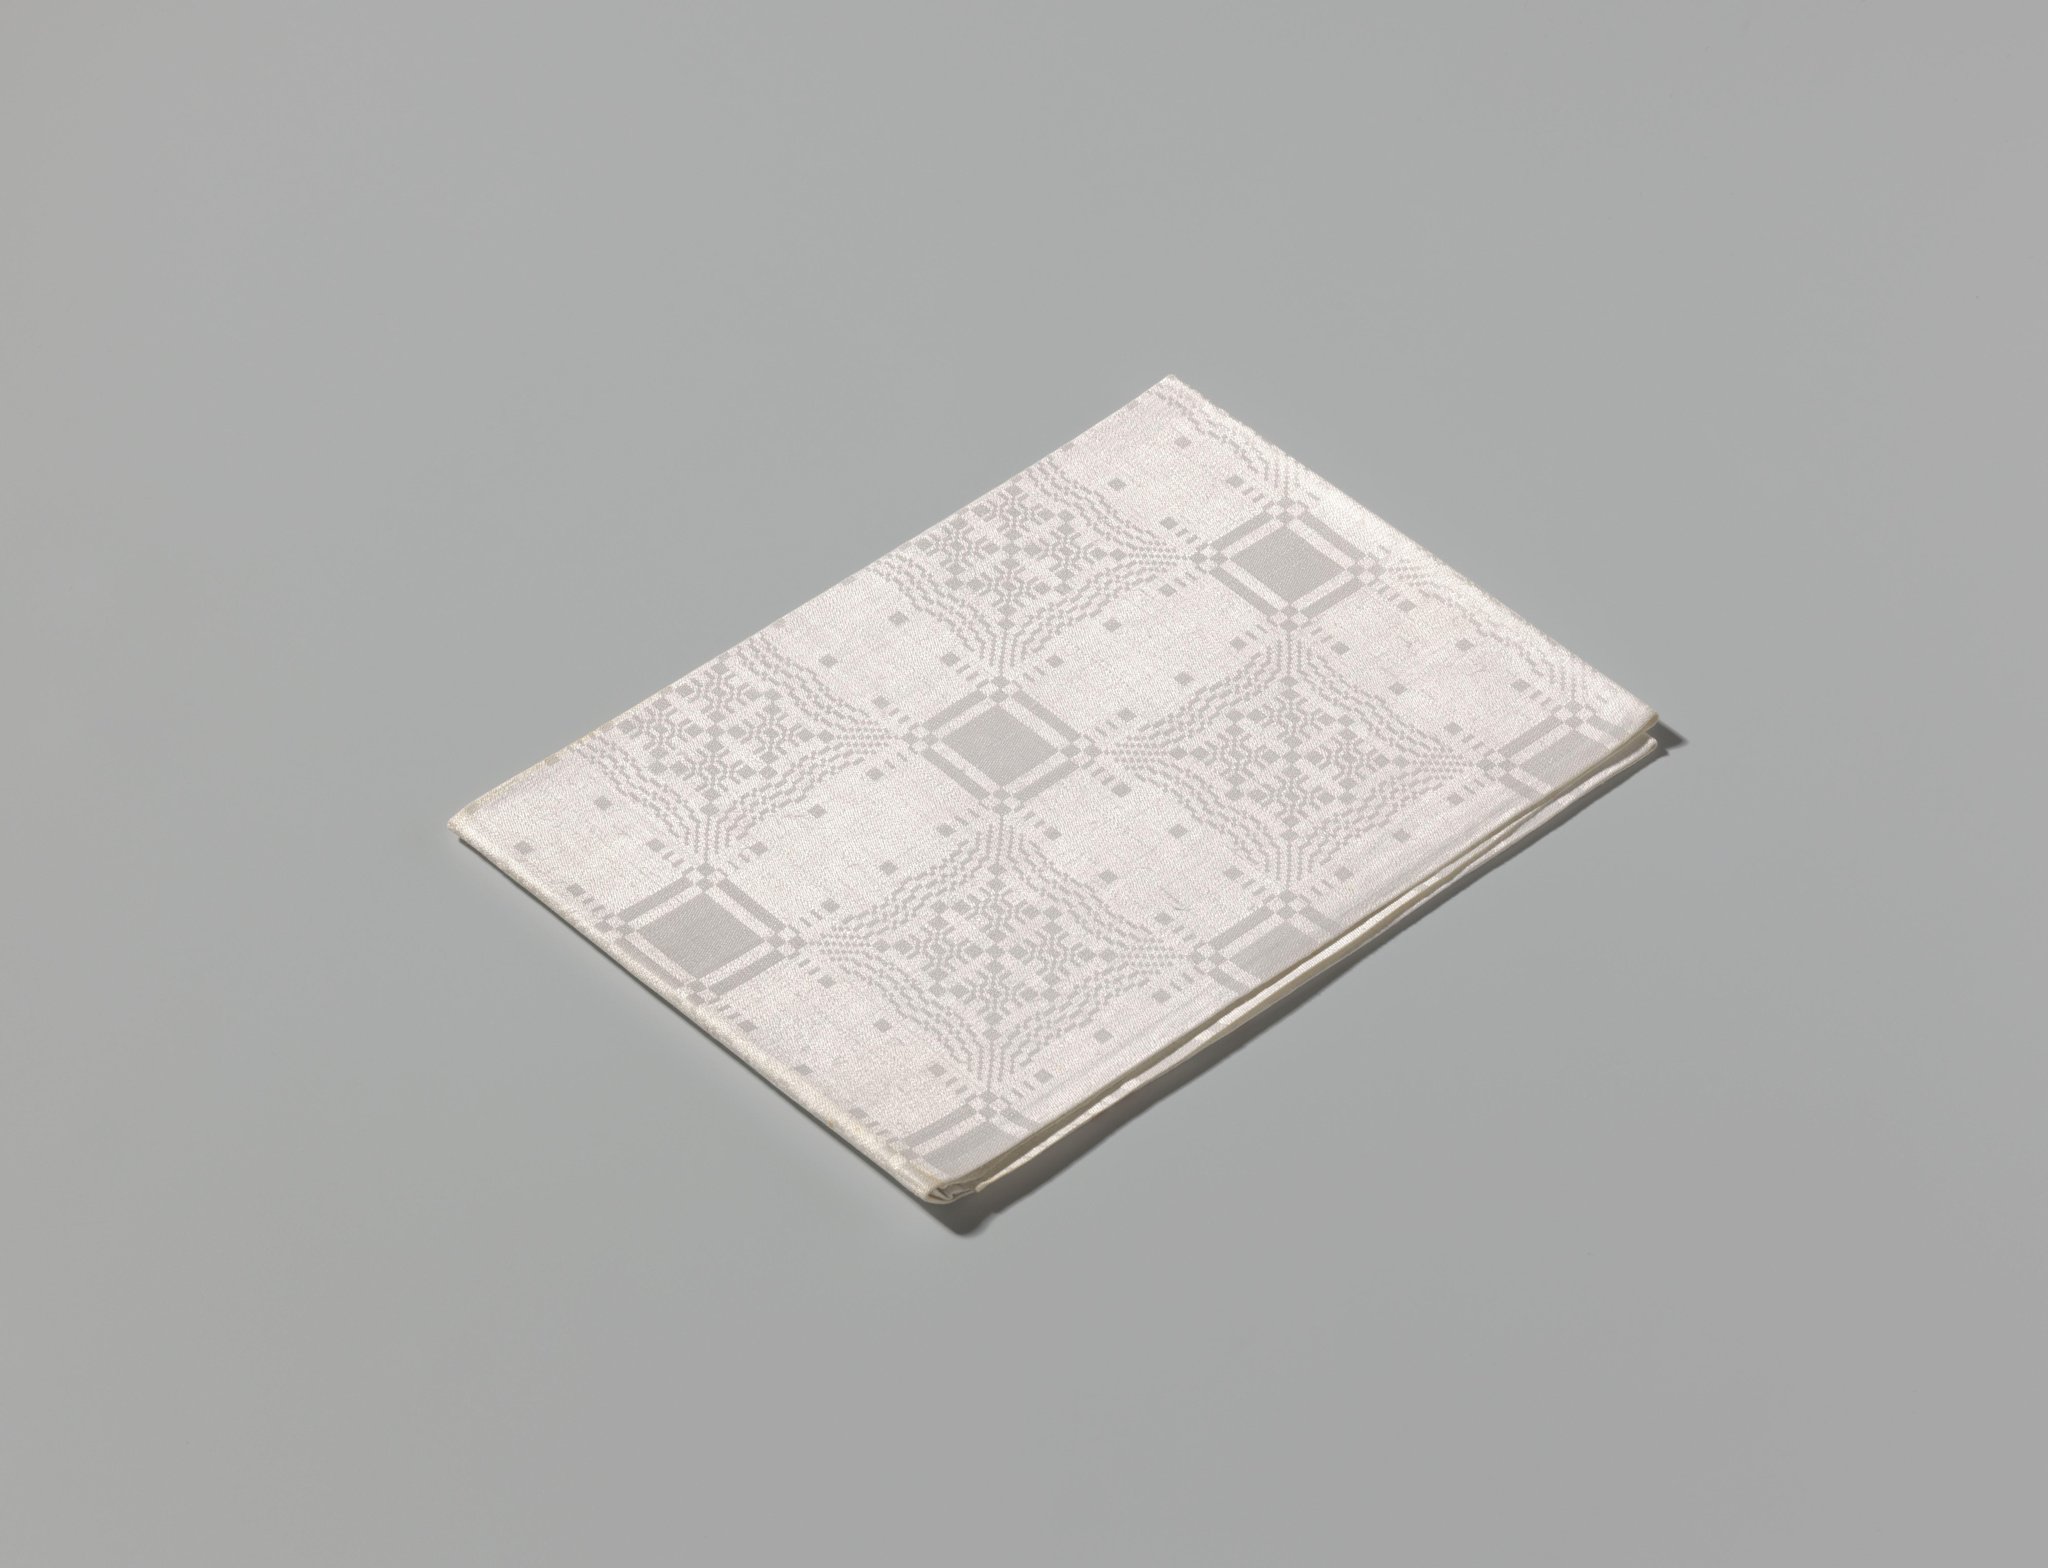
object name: napkin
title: Servet van linnen met pellenpatroon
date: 1734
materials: linen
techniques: peeled fabric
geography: northern netherlands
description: wit linnen servet met pellen patroon, merk AVG 38 en 1734